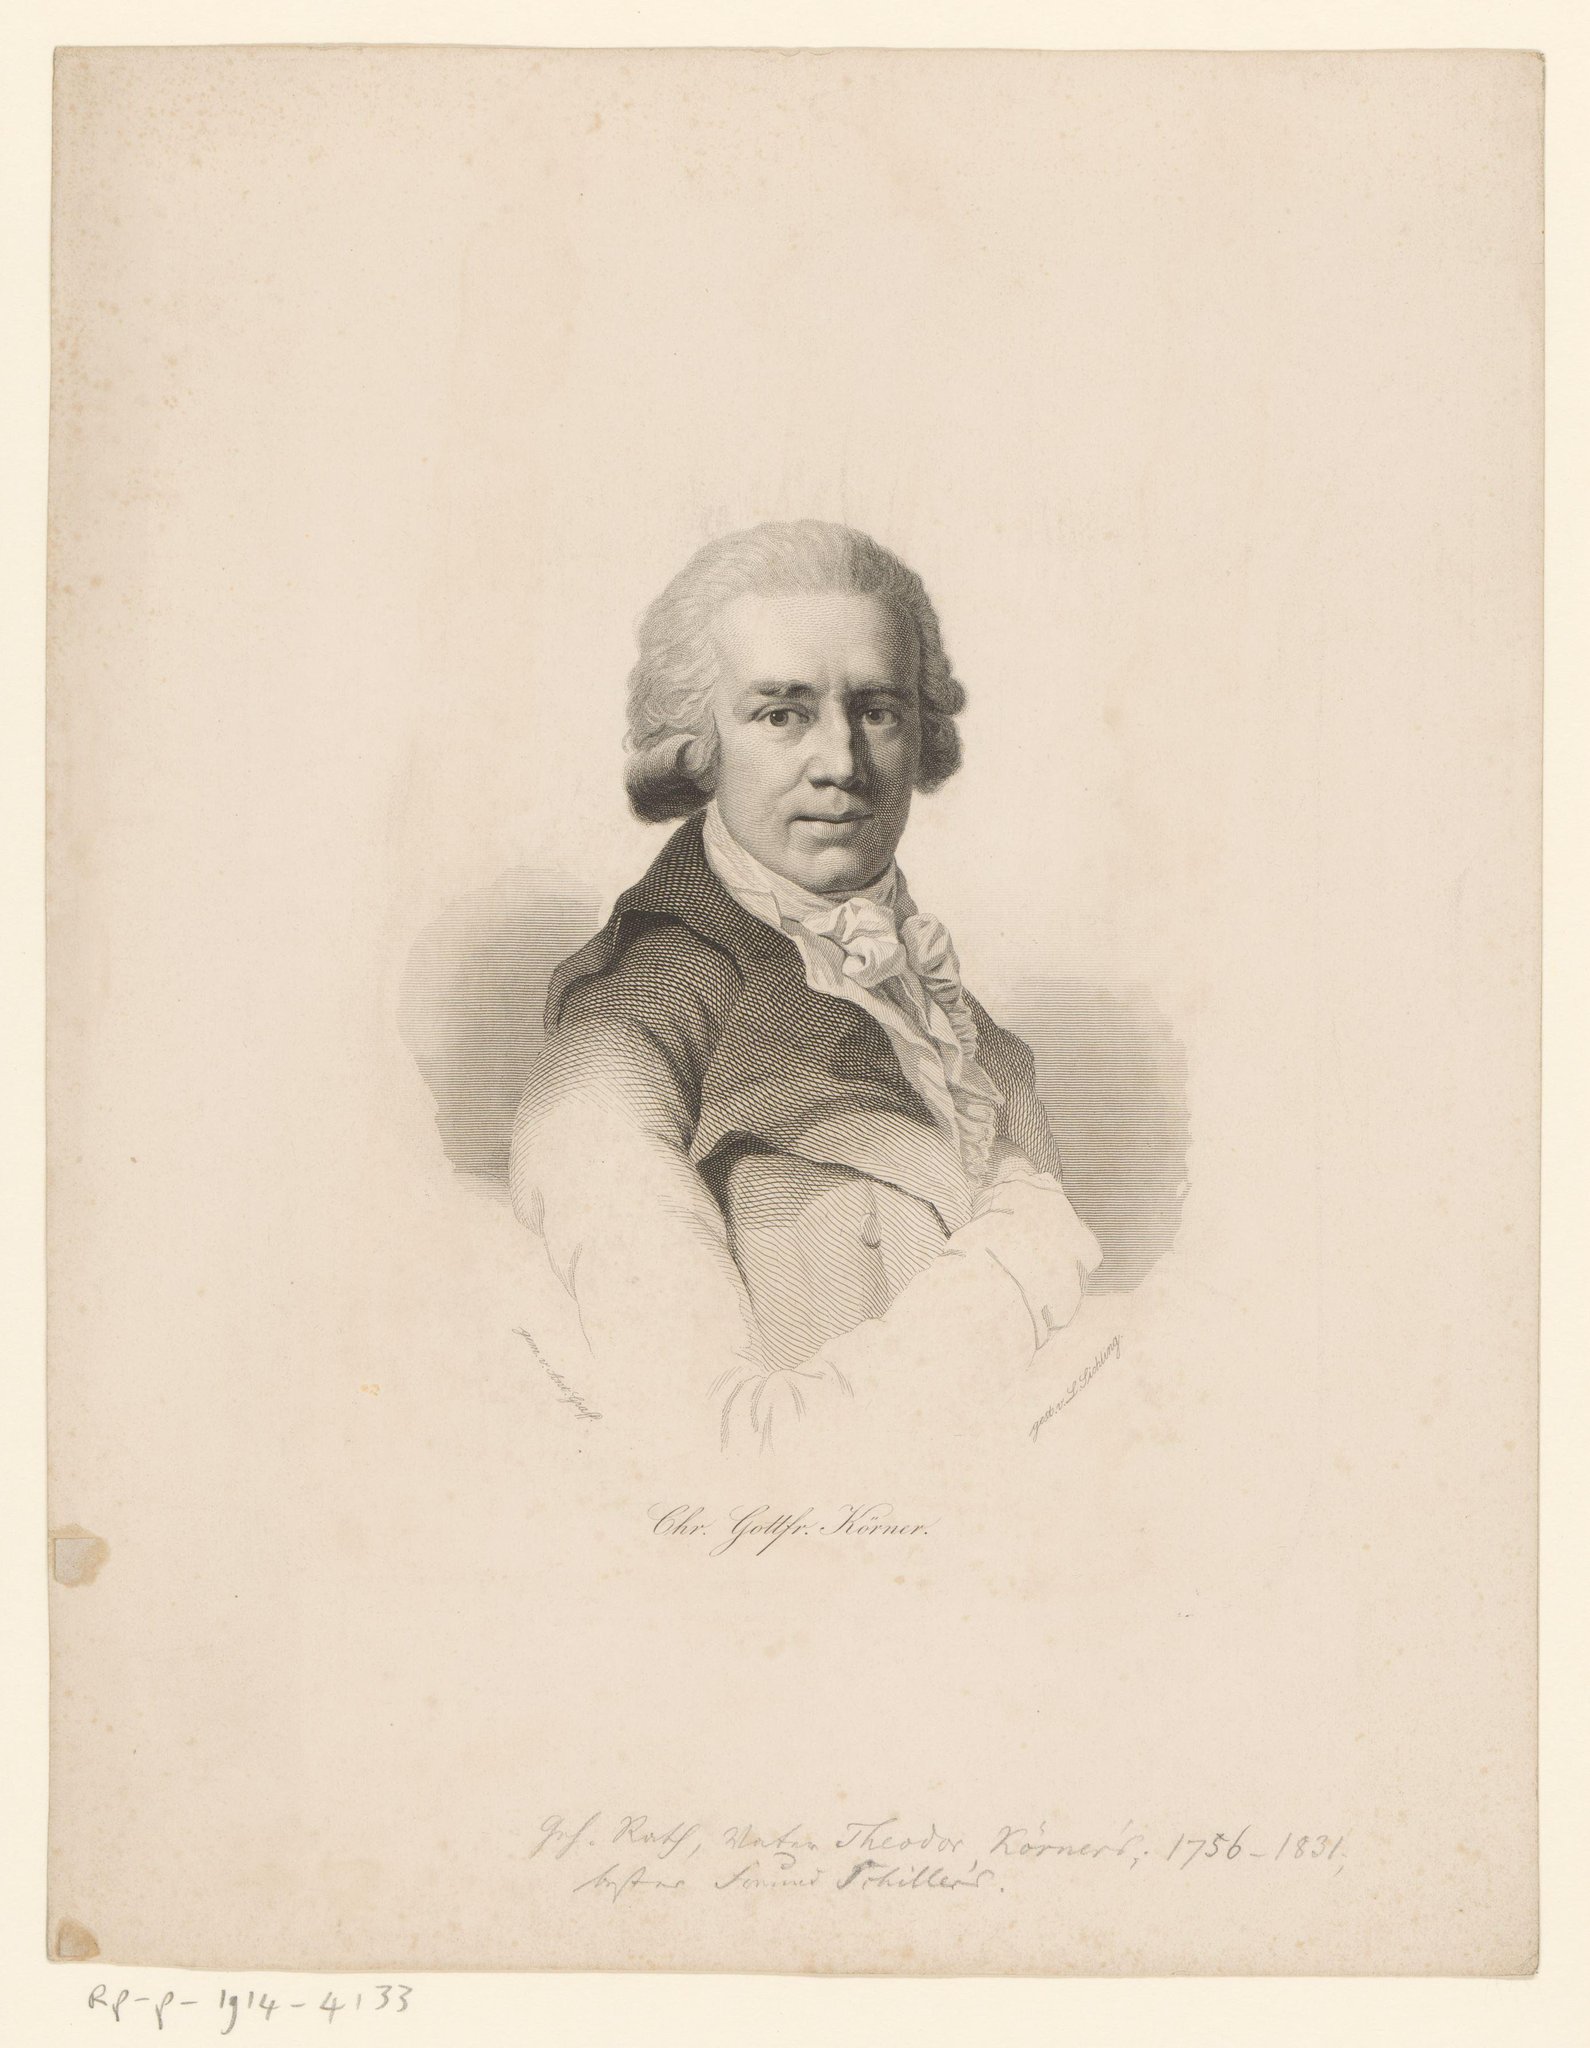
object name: print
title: Portret van Christian Gottfried Körner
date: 1822-1863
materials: paper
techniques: engraving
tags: berlin, historical persons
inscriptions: collector's mark: Lugt 2228